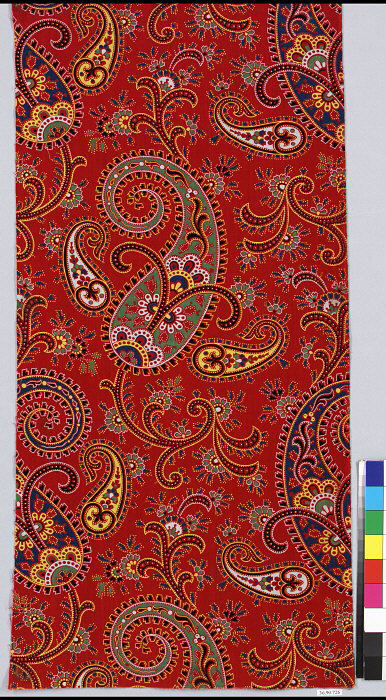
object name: piece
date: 1867-1900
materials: cotton